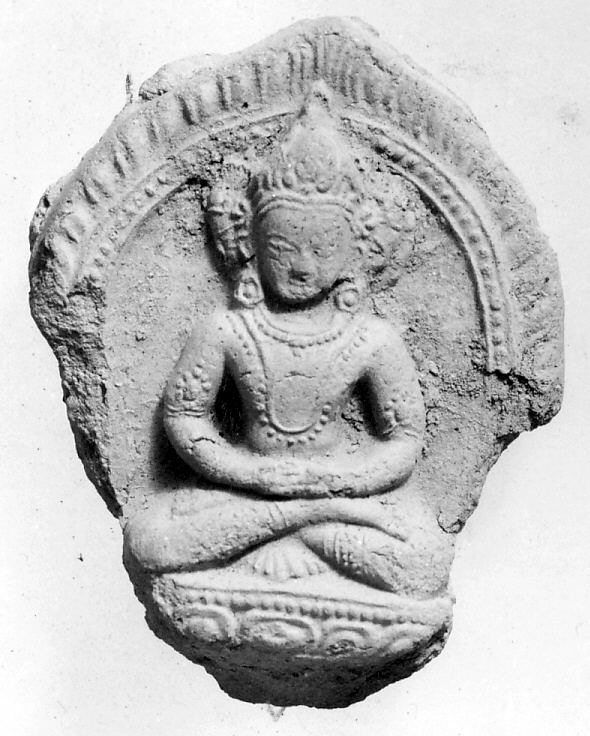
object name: votive plaque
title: Votive Plaque with Seated Bodhisattva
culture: tibetan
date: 901-1600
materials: clay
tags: buddhism,bodhisattvas